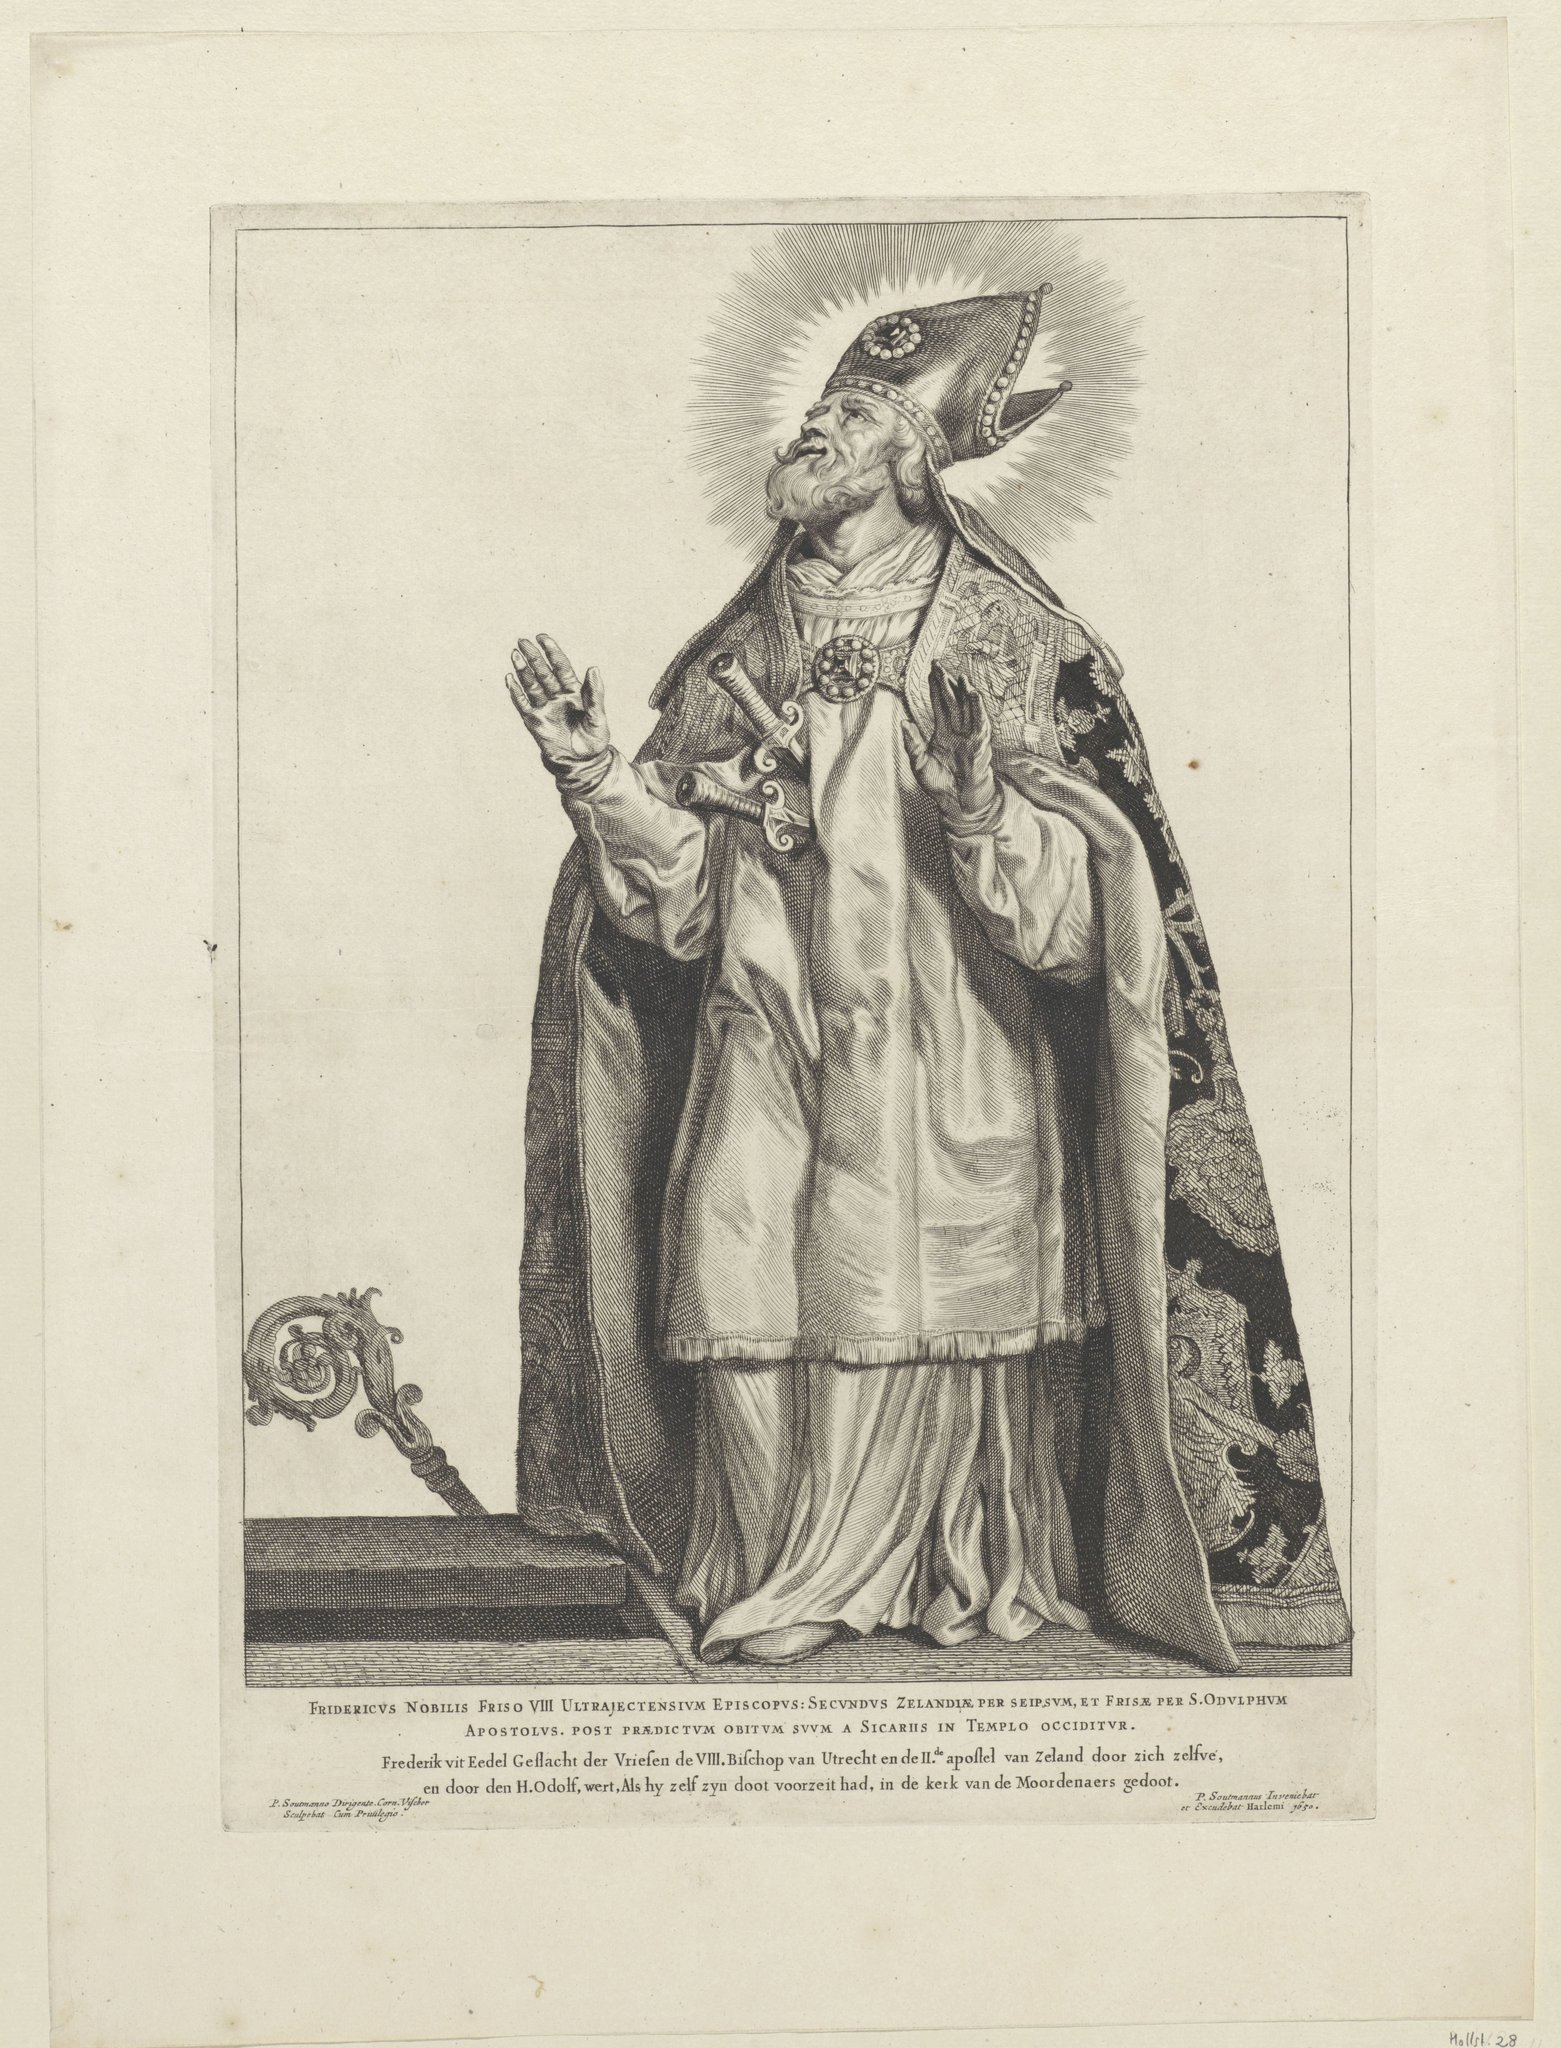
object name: print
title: Nederlandse heiligen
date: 1650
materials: paper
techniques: engraving, etching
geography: haarlem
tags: heilige, fredericus i van utrecht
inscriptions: collector's mark: Lugt 240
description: Deze prent maakt deel uit van de serie: Iesv Christo, Fideli Militantis Ecclesiae Imperatori, Liberali Eivsdem, Trivmphantis, Remvneratori, hos In Foederato Belgio Militiae Svae Legatos, Sanctissimos Sacri Belli Dvces, Patriae Apostolos, Et Decora Lvmina, Cvm Dvabvs Heroinis, Militans In Iisdem Provinciis Ecclesia. Haarlem: Pieter Claesz. Soutman, 1650.